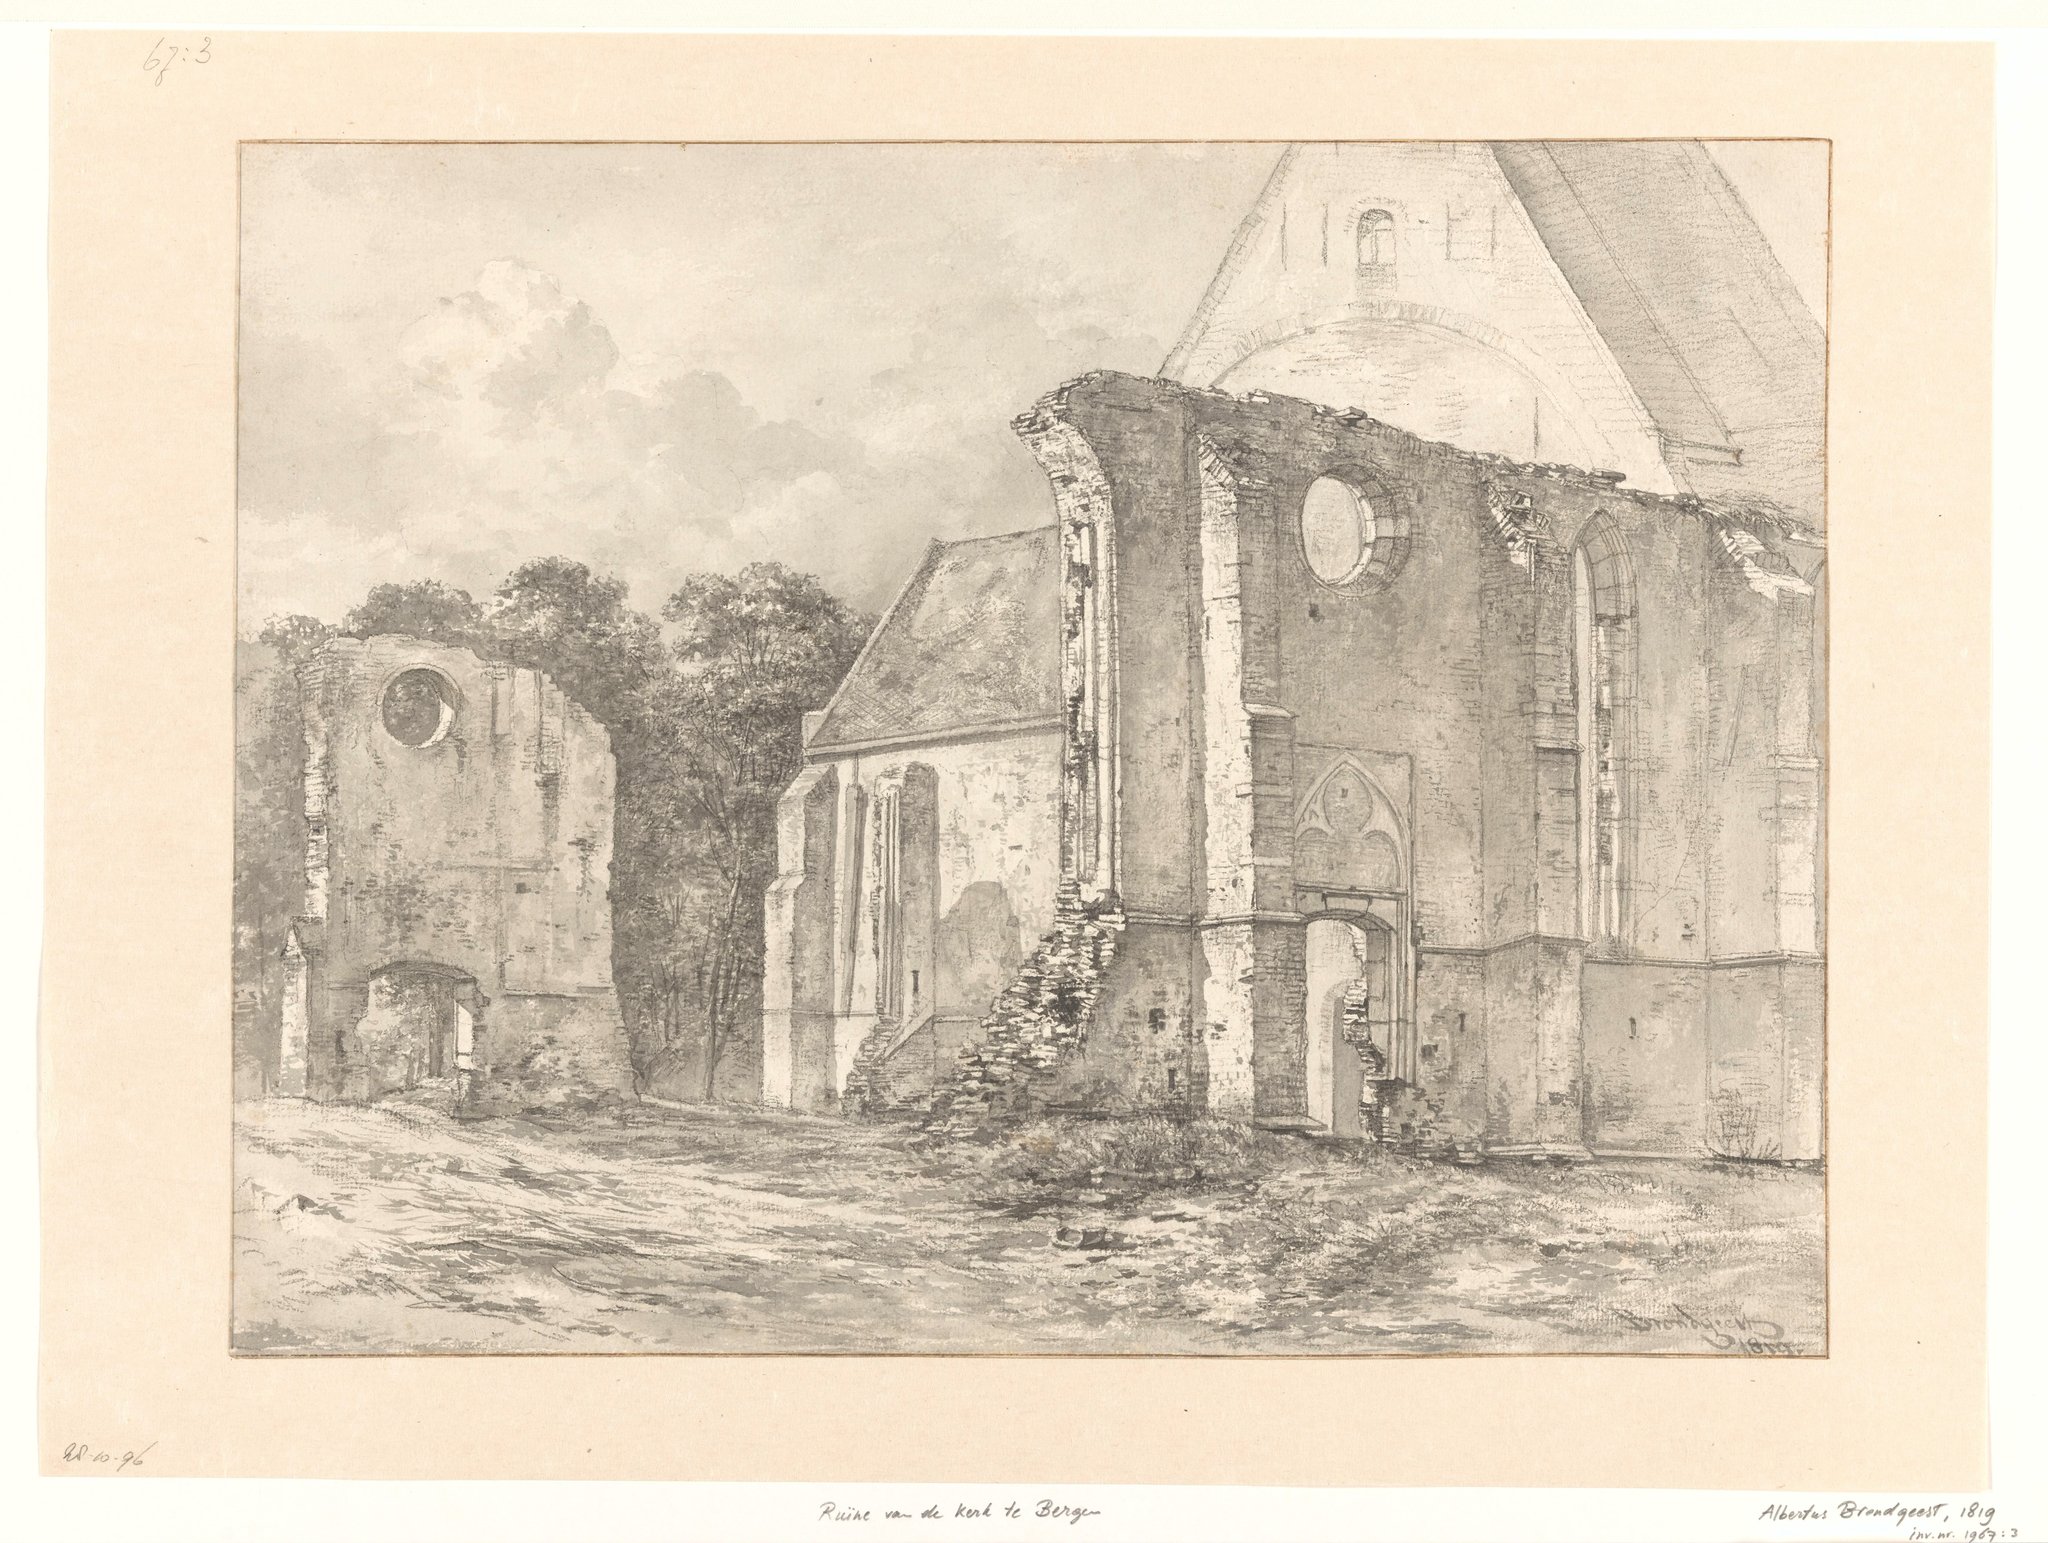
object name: drawing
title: De kerkruïne te Bergen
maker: albertus brondgeest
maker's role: draughtsman, print maker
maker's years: 1786-1849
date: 1819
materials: chalk, paper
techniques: brush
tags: ruin of a building ~ architecture, church (exterior)